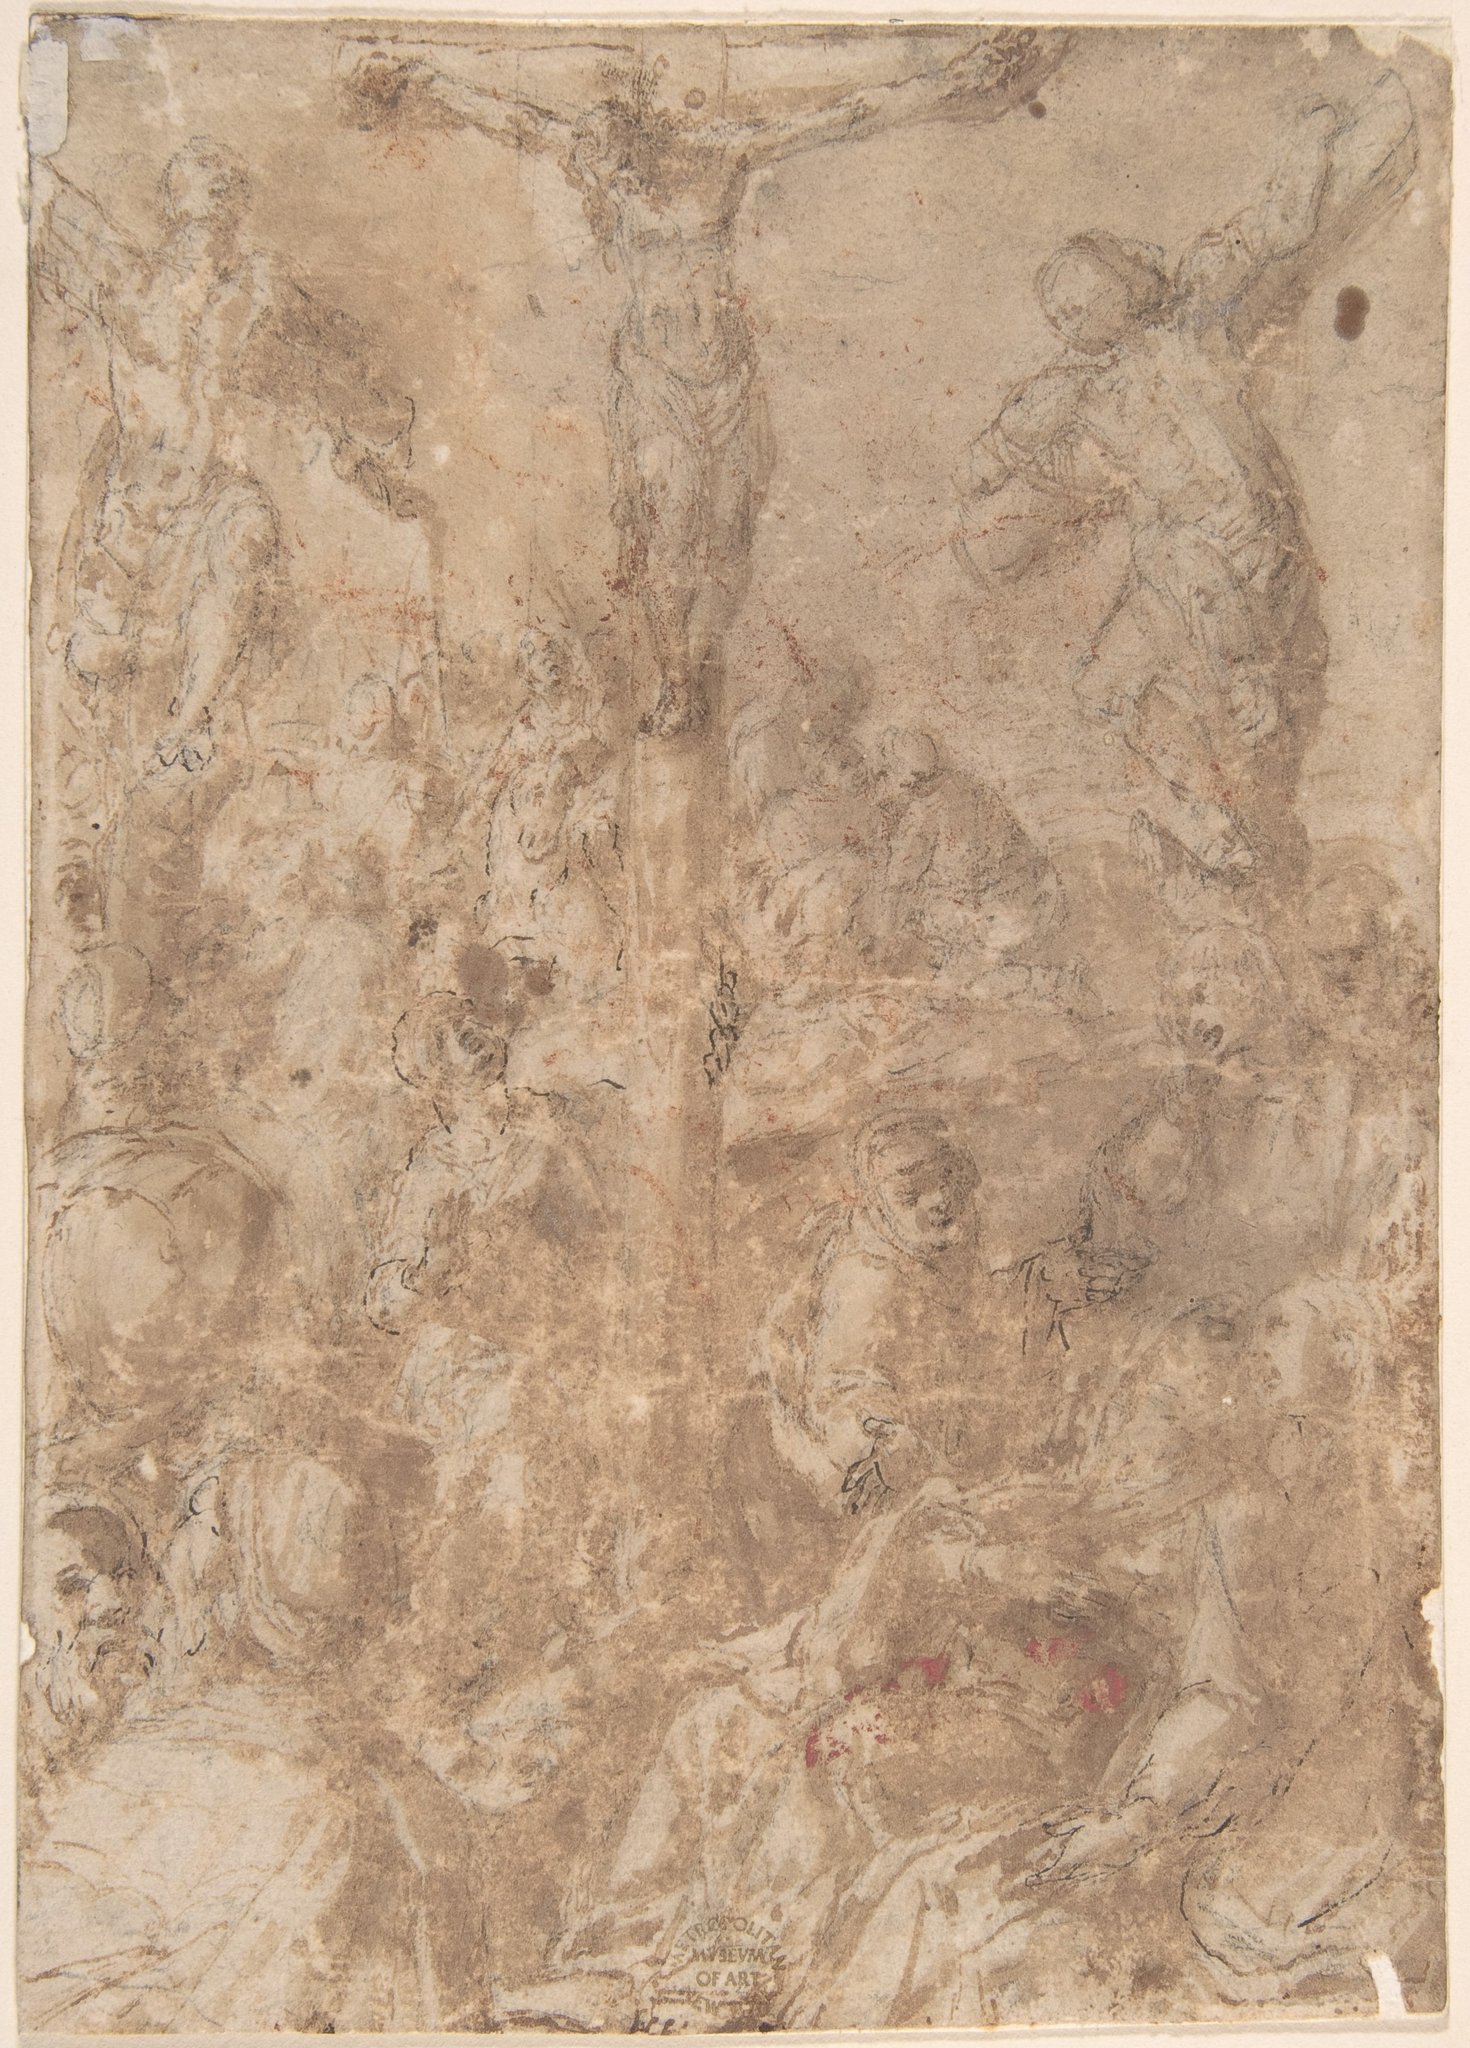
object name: drawing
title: Crucifixion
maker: anonymous, italian, 16th century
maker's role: artist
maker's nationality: italian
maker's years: 1550-1600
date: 1501-1600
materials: ink, paper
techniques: brush, pen, wash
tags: human figures,christ,crucifixion